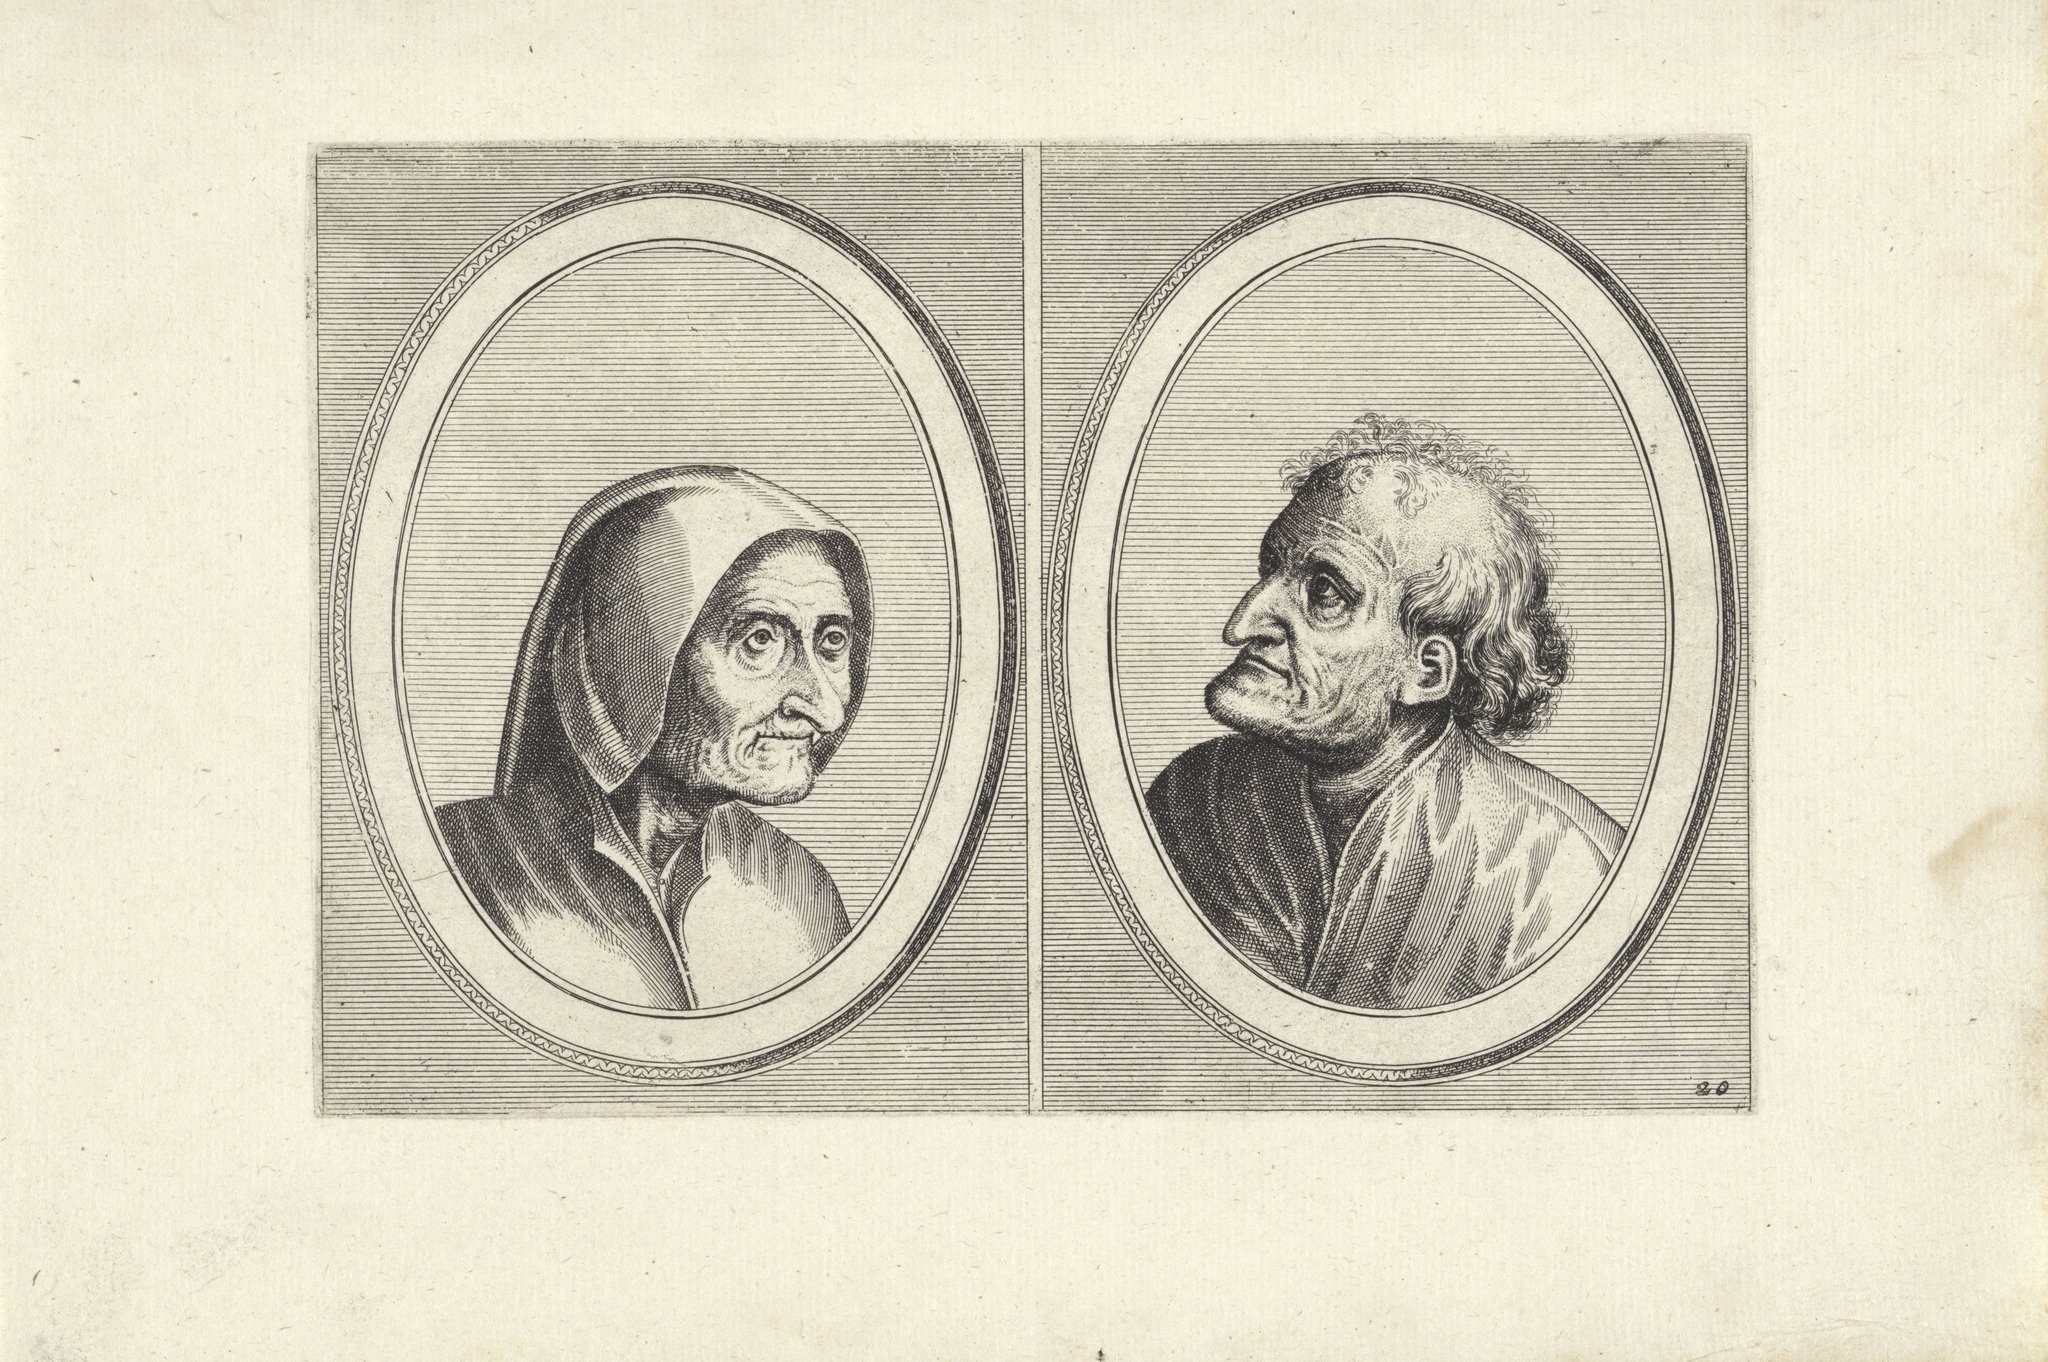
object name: print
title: Boerenkoppen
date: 1612-1652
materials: paper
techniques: engraving, etching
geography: amsterdam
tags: head-gear, farmers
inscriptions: collector's mark: Lugt 2228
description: Prent uit een serie van 36 prenten met koppen van boeren en boerinnen.